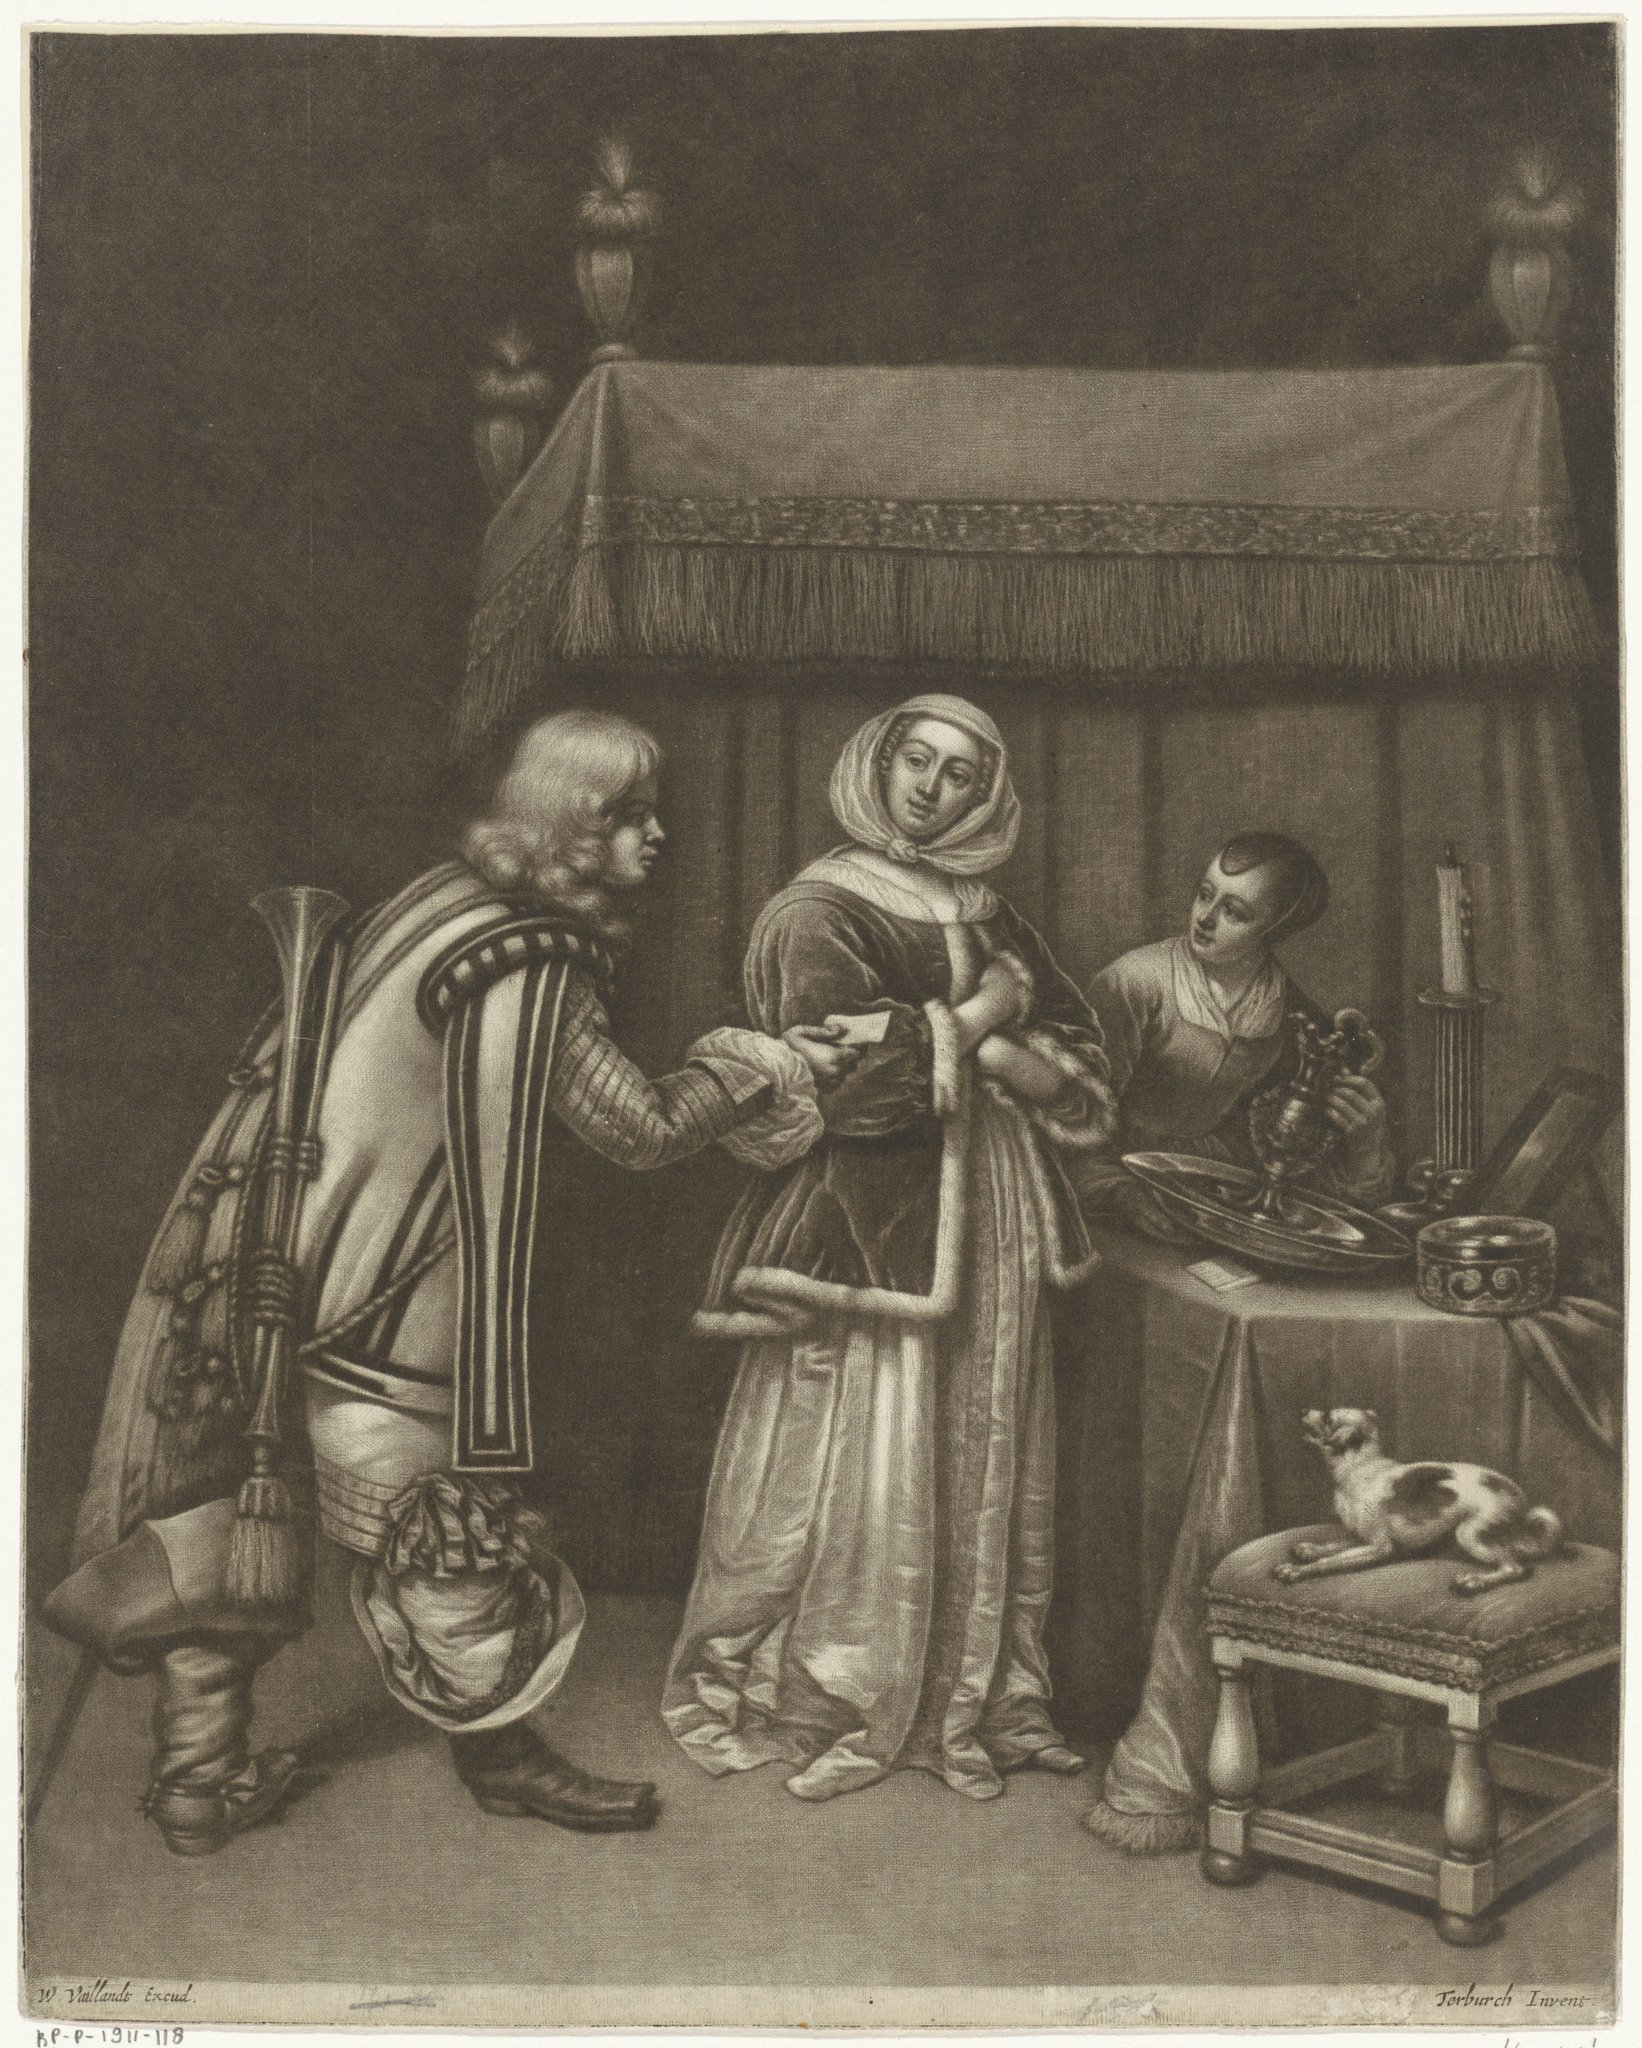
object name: print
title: Geweigerde brief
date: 1668-1677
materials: paper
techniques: mezzotint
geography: amsterdam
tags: letter, envelope, dog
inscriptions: collector's mark: Lugt 2228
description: Een boodschapper, met op zijn rug een bazuin, reikt een vrouw een brief aan. Zij lijkt de brief niet aan te willen nemen, ze heeft haar armen over elkaar geslagen.